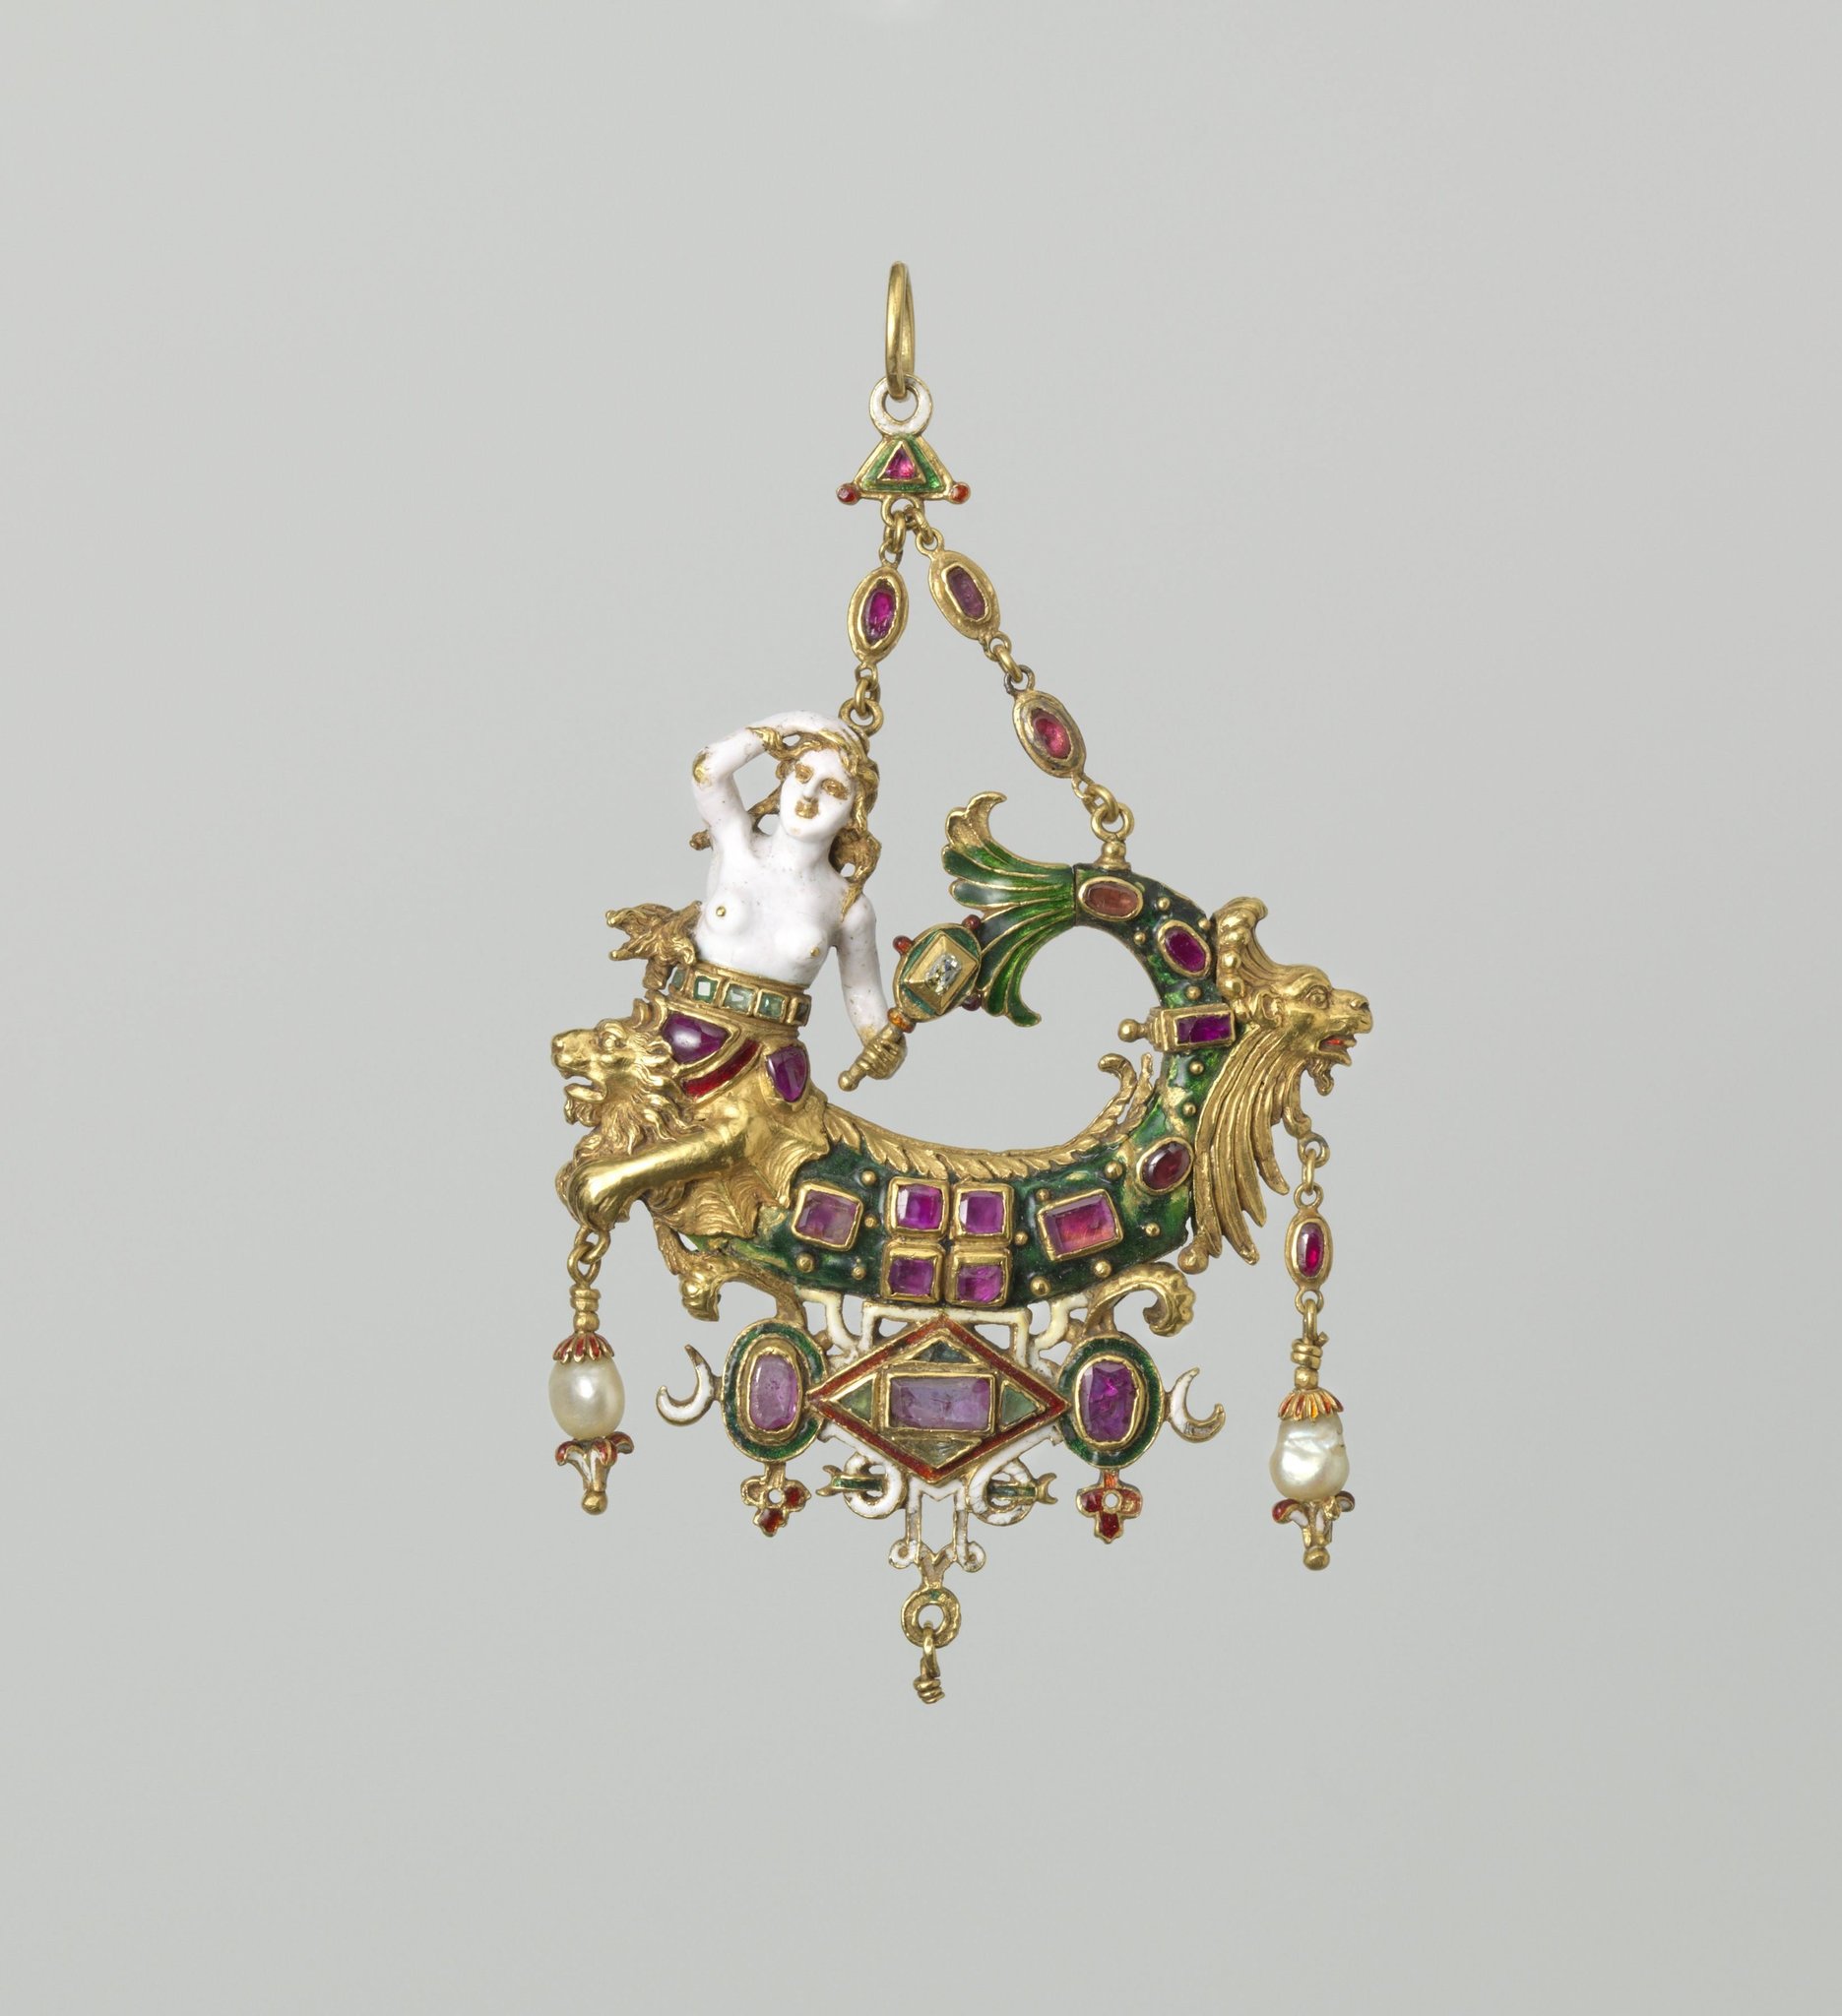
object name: pendant jewelry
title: Hanger in de vorm van een zeemeermin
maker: Anonymous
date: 1800-1900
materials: gemstone, gold, pearl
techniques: enameling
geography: italy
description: Hanger in de vorm van een zeemeermin, van goud, email, robijnen, smaragden en parels.